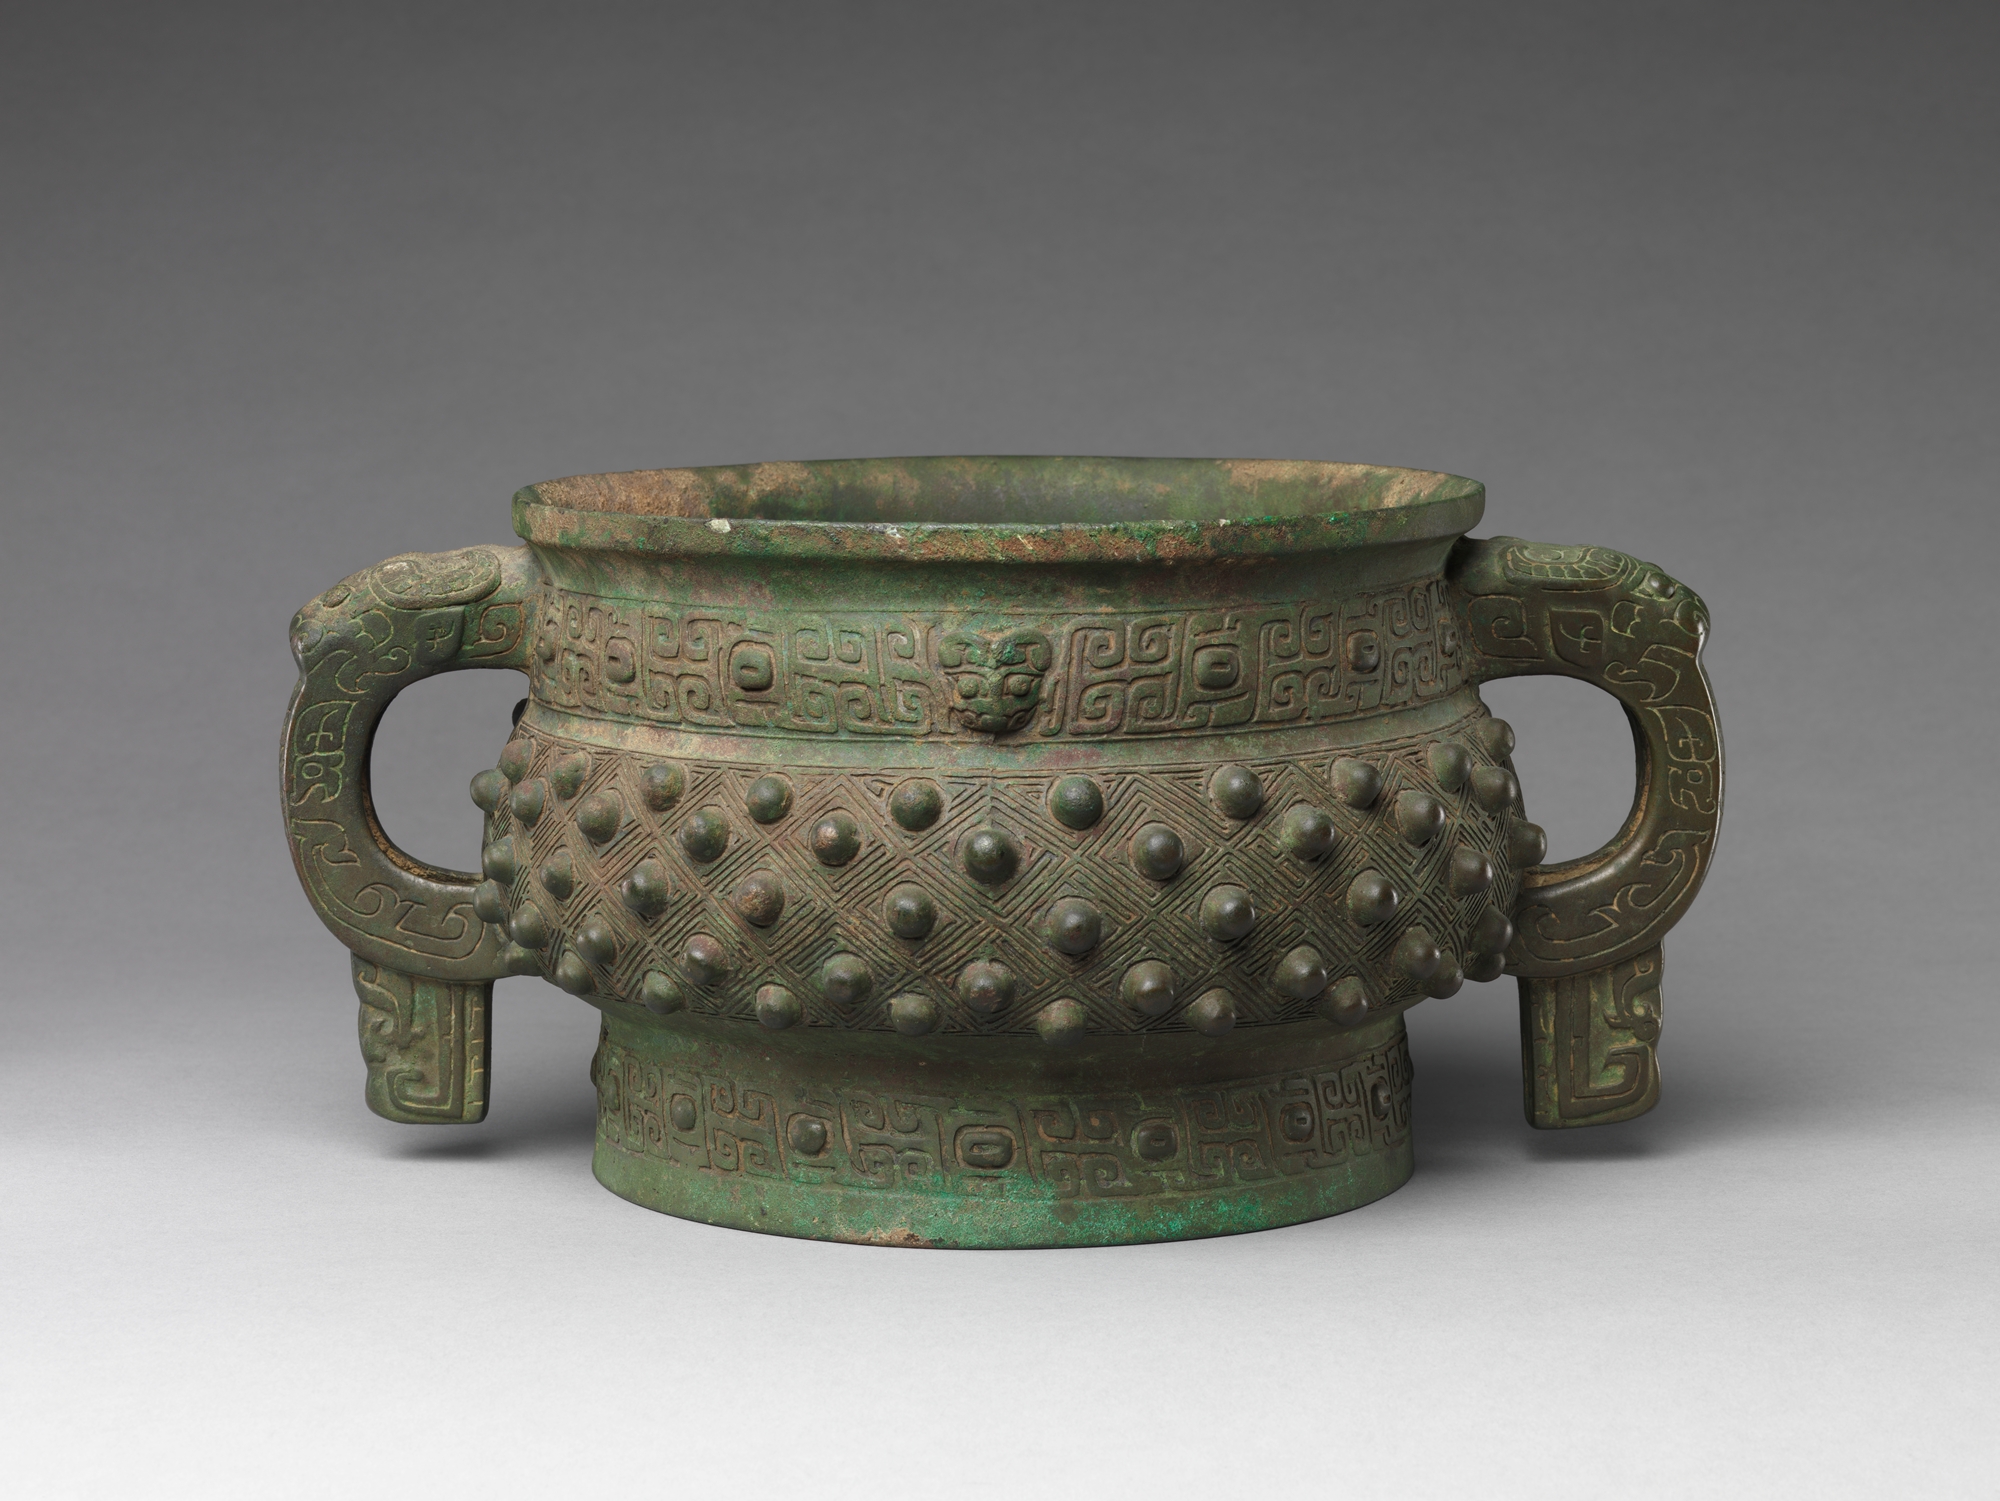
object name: vessel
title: Grain serving vessel (Gui)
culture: chinese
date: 1000-901 BCE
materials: bronze